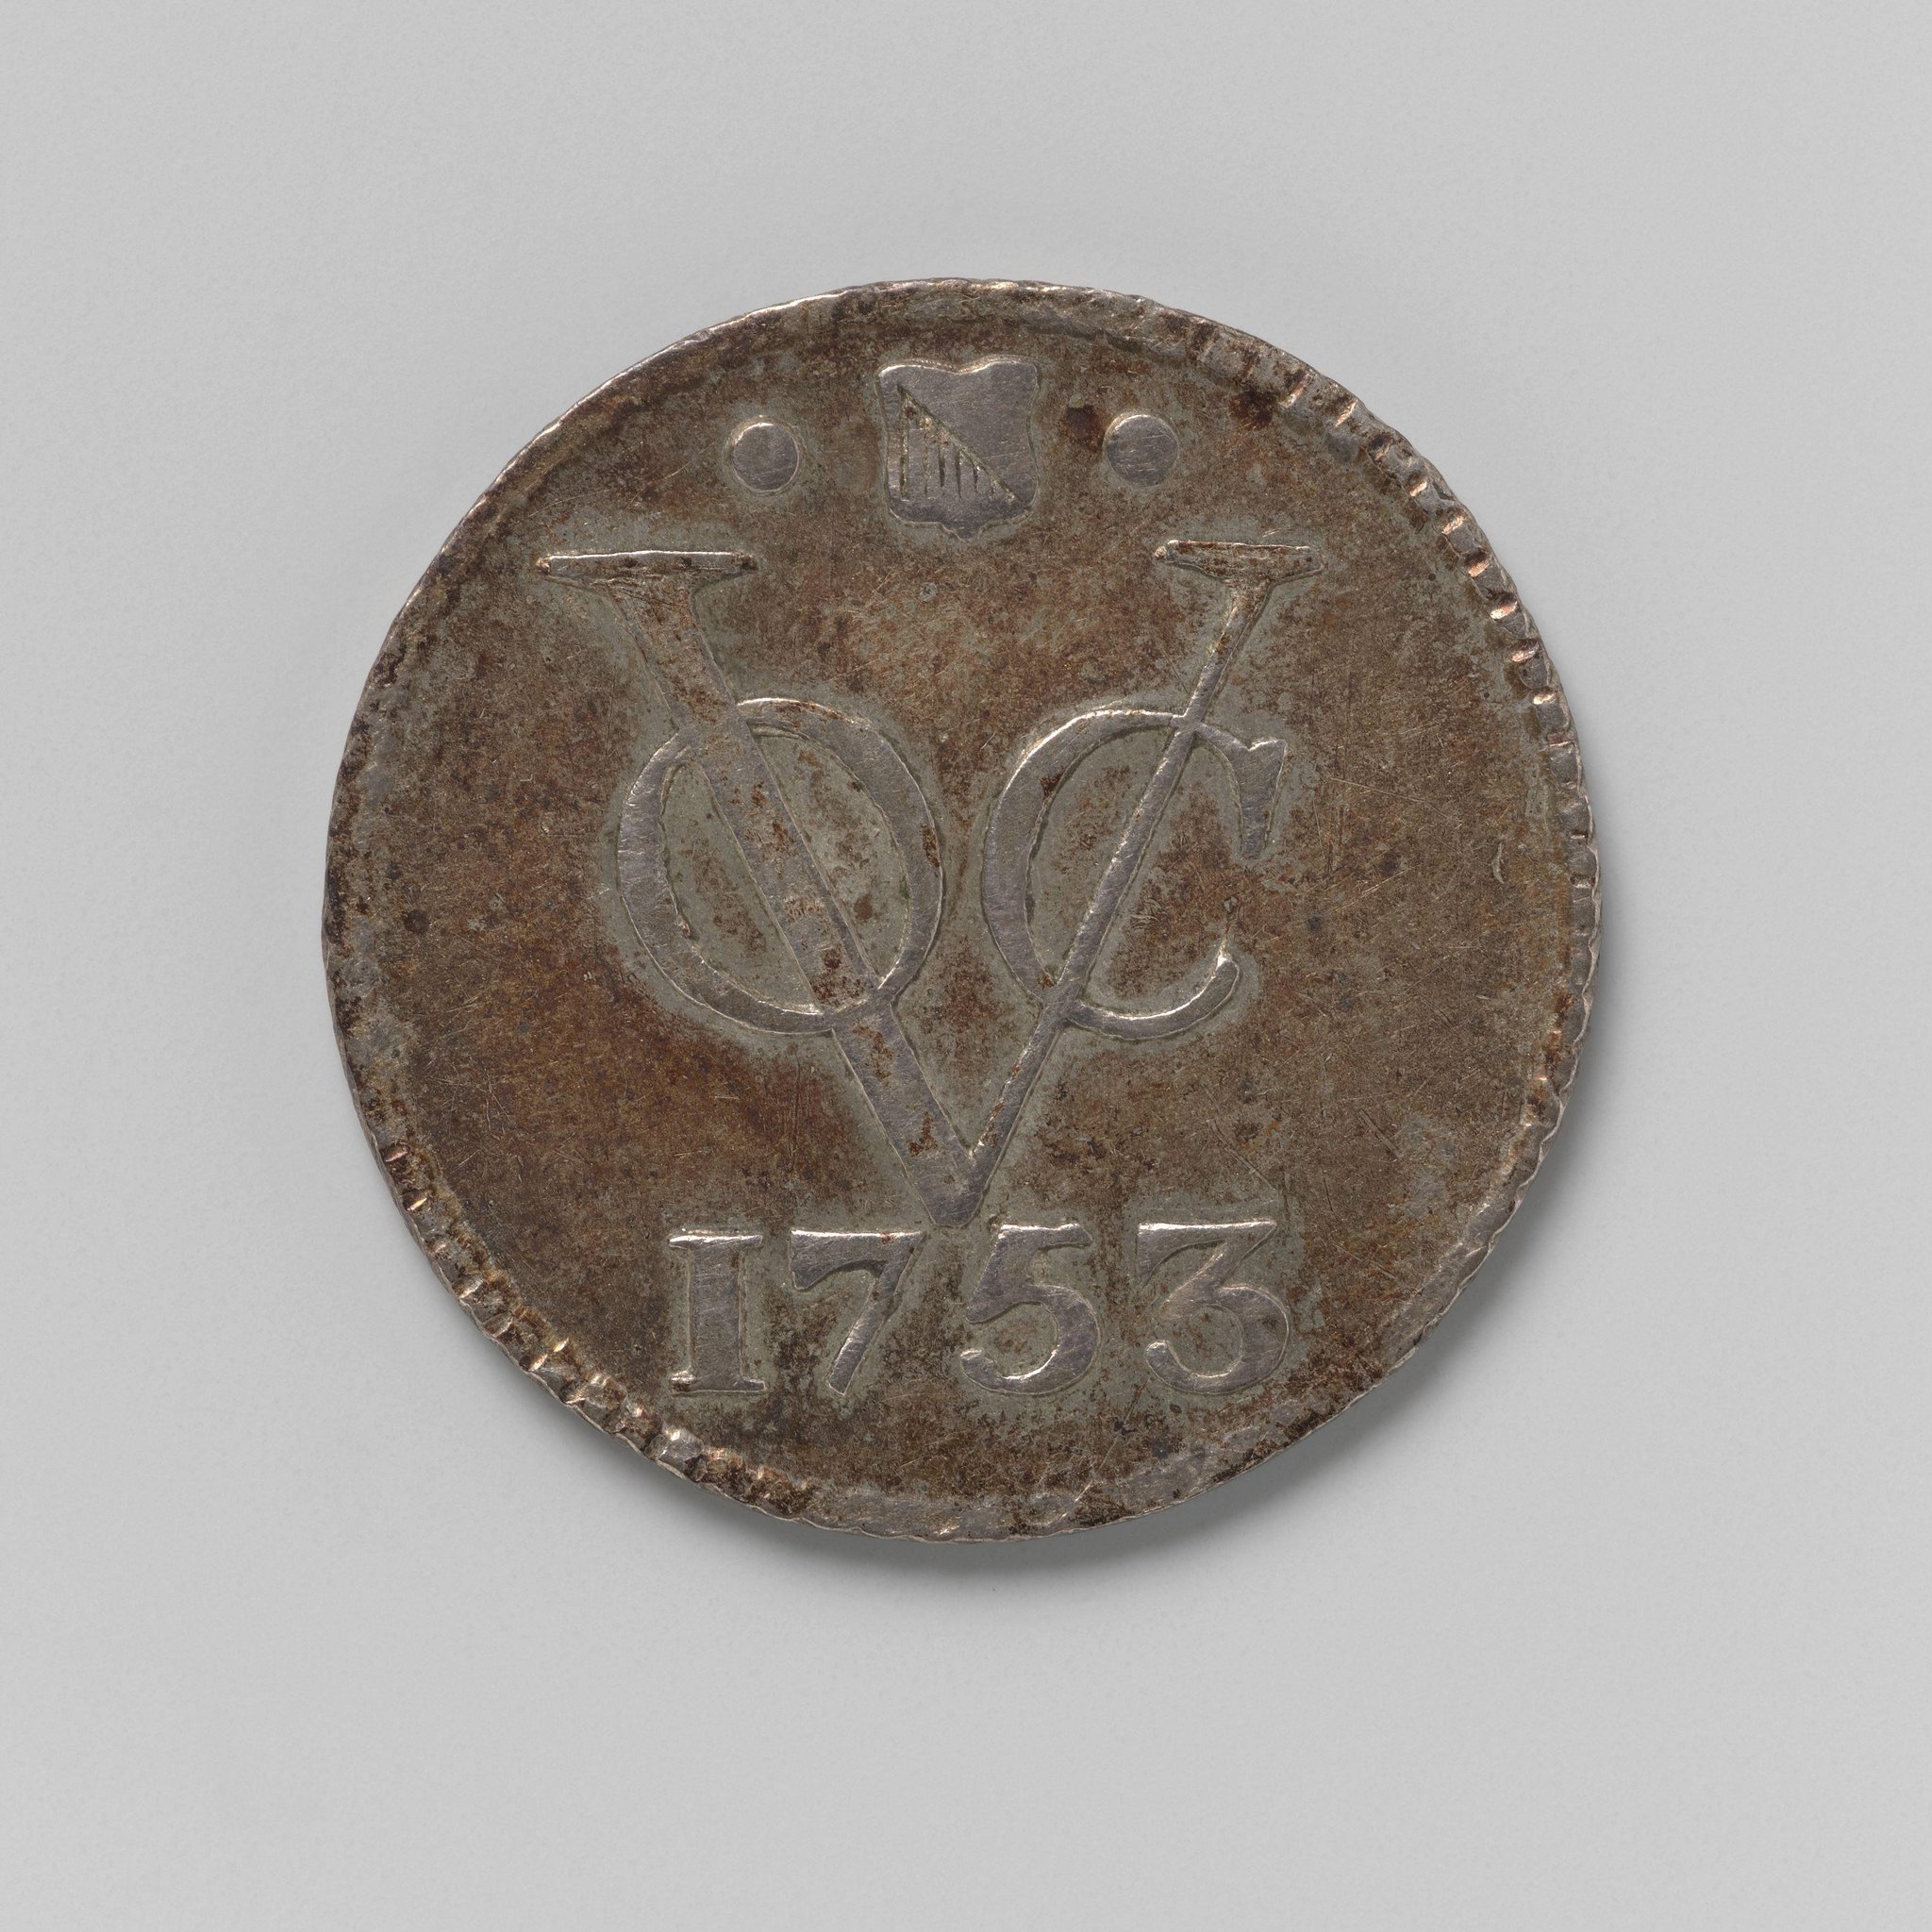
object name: coin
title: VOC, duit, stad Utrecht,1753. Afslag in zilver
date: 1753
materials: silver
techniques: striking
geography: utrecht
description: Zilveren munt. Voorzijde: op balk, waaronder guirlande, staand, door twee leeuwen gehouden gekroond wapenschild van de stad Utrecht. Keerzijde: monogram van de VOC, waarboven muntteken en waaronder jaartal. Kabelrand.